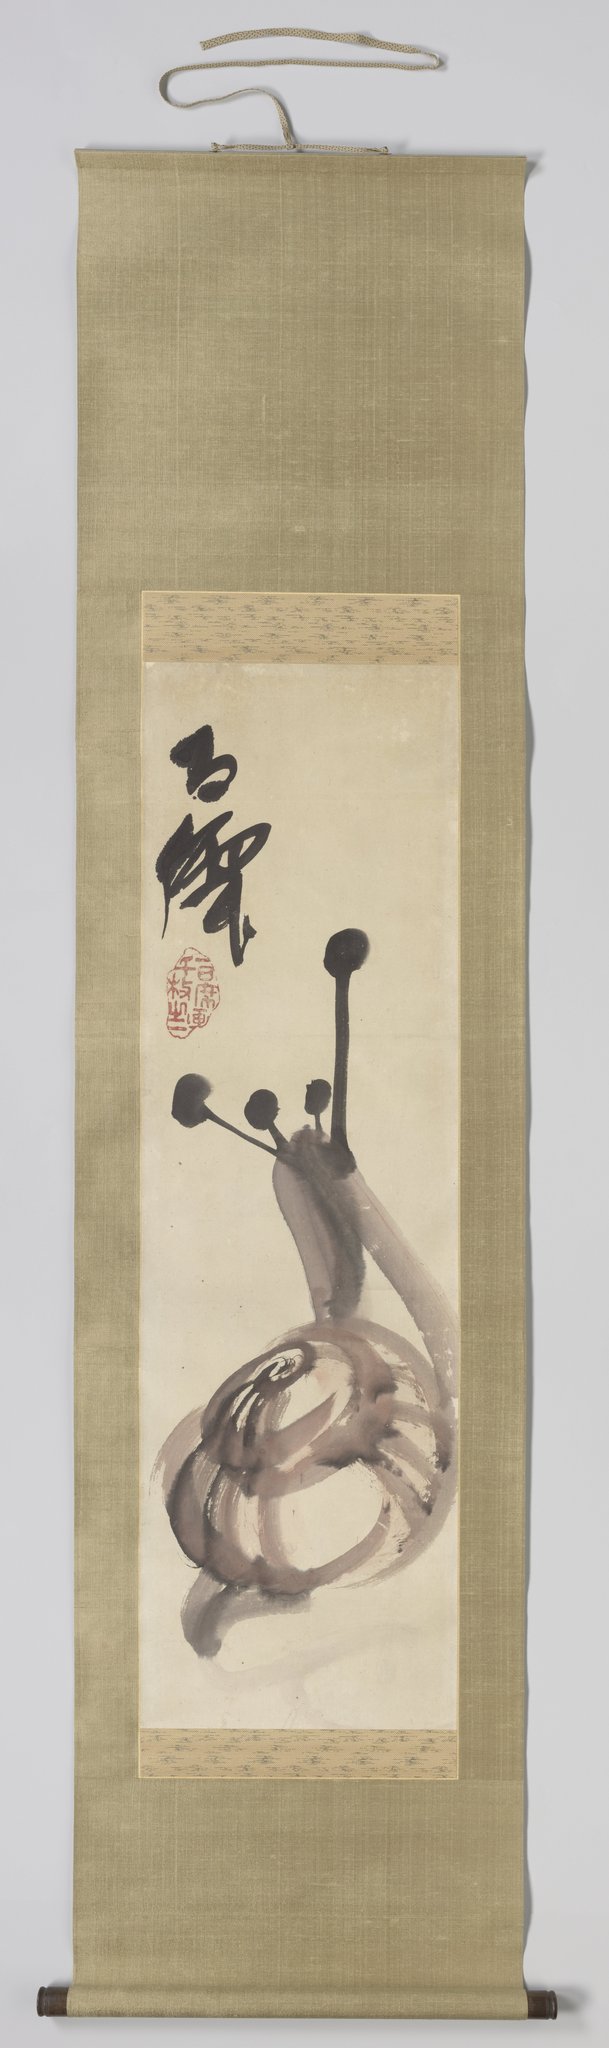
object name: hanging scroll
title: Snail (katatsumuri)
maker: suzuki shônen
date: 1859-1918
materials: paper, silk, wood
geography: japan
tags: molluscs: snail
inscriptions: seal, signature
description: With energetic brushwork Suzuki Shonen enlarged the snail until it filled the picture plane. This bravura is also expressed in the enormous signature, and emphasized again in the text of the seal: ‘one sheet out of a thousand, painted in a one day.’ Shonen would have been a young man when he accomplished this tour de force.